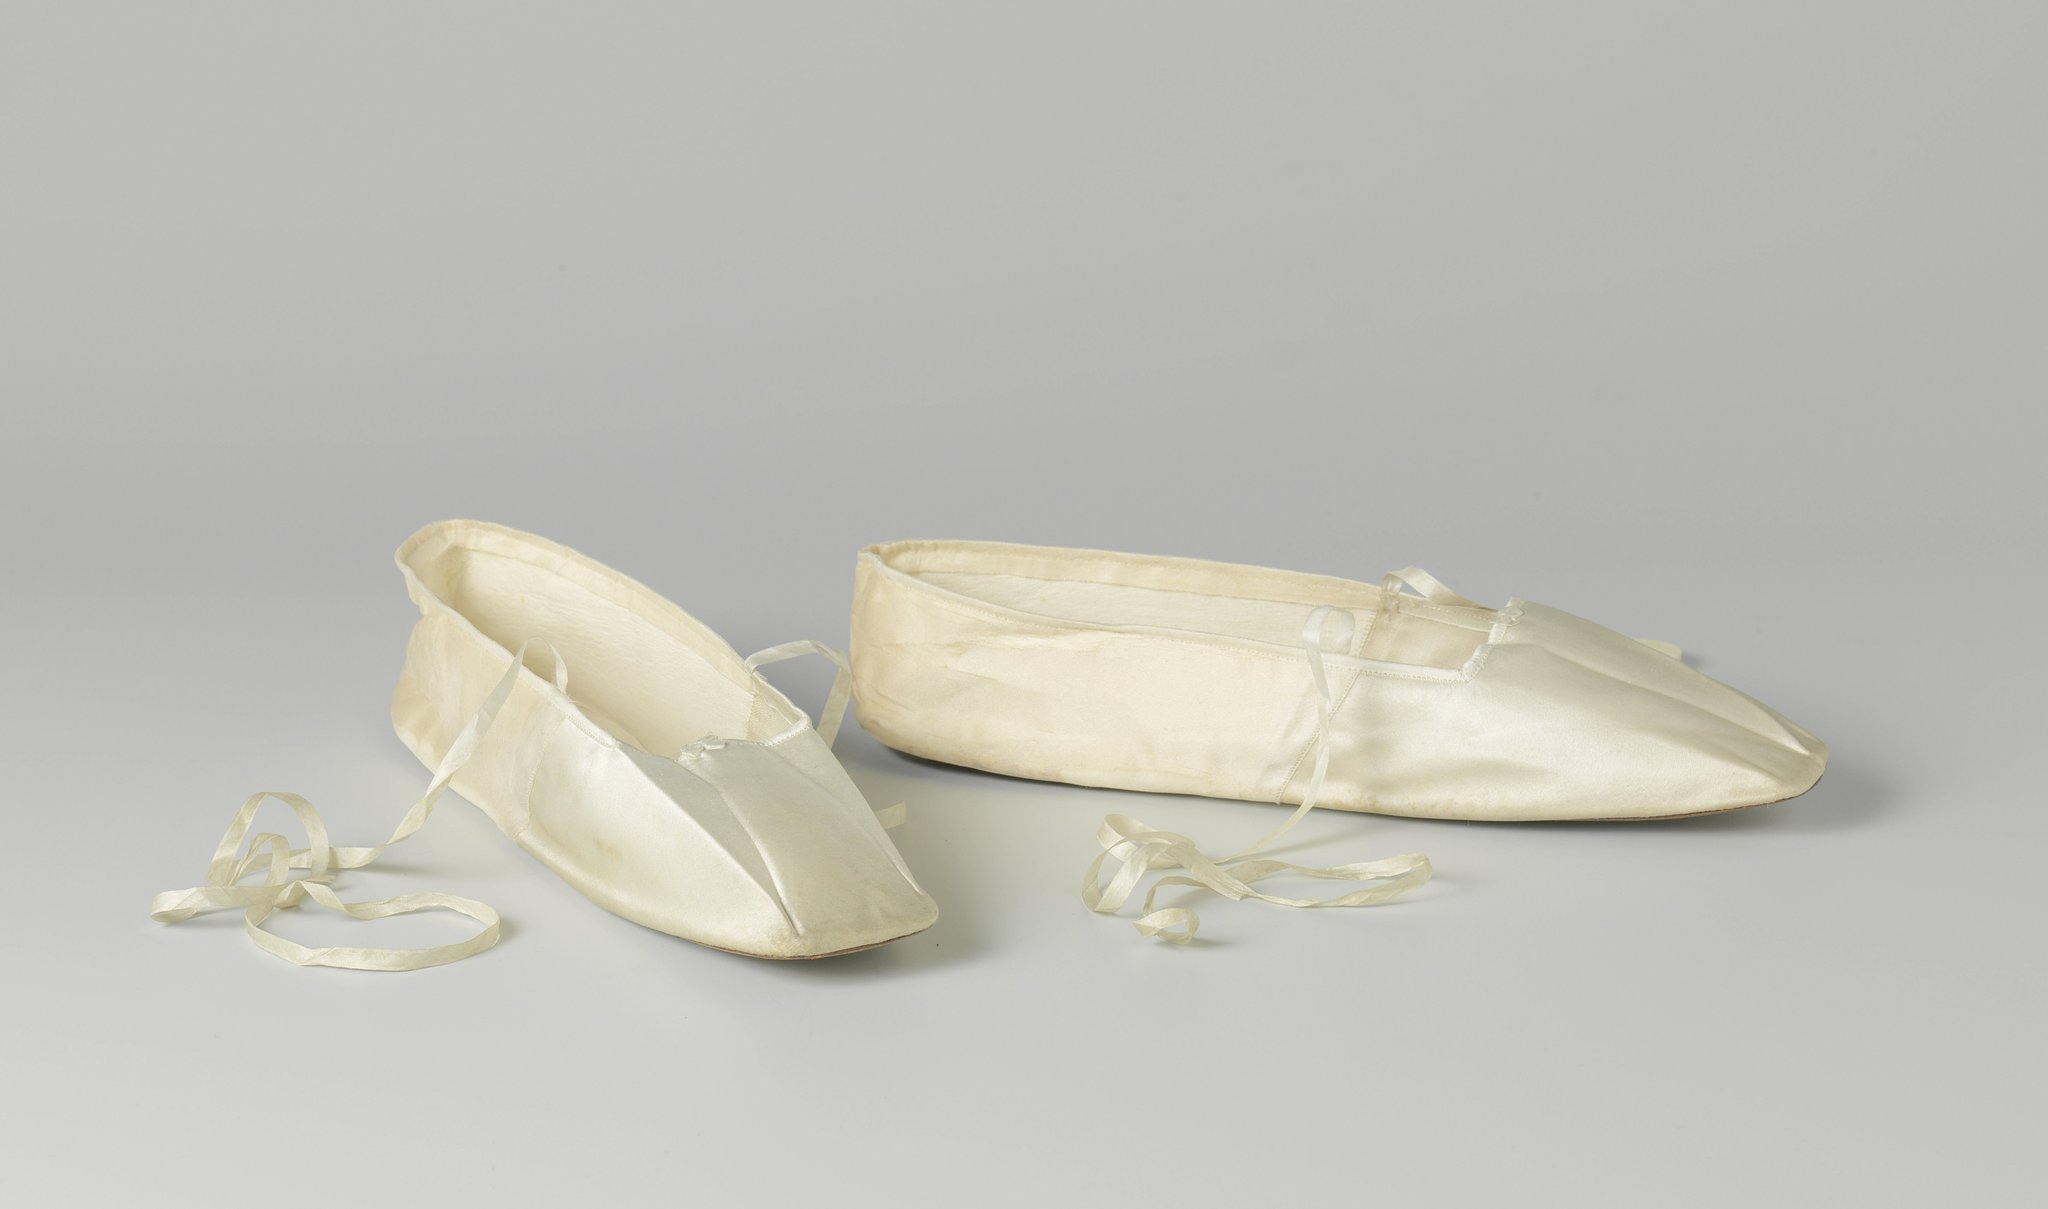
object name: shoe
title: Pair of shoes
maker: Anonymous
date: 1815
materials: cotton, leather, silk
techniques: tanning, weave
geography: netherlands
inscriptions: : ‘Droit’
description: These shoes did not have a specific fit for right or left. The shoes would mould themselves to the feet while being worn. In the early 19th century, shoes began to be labelled for which foot they were meant: stamped on the insoles are the words droit (right) and gauche (left).